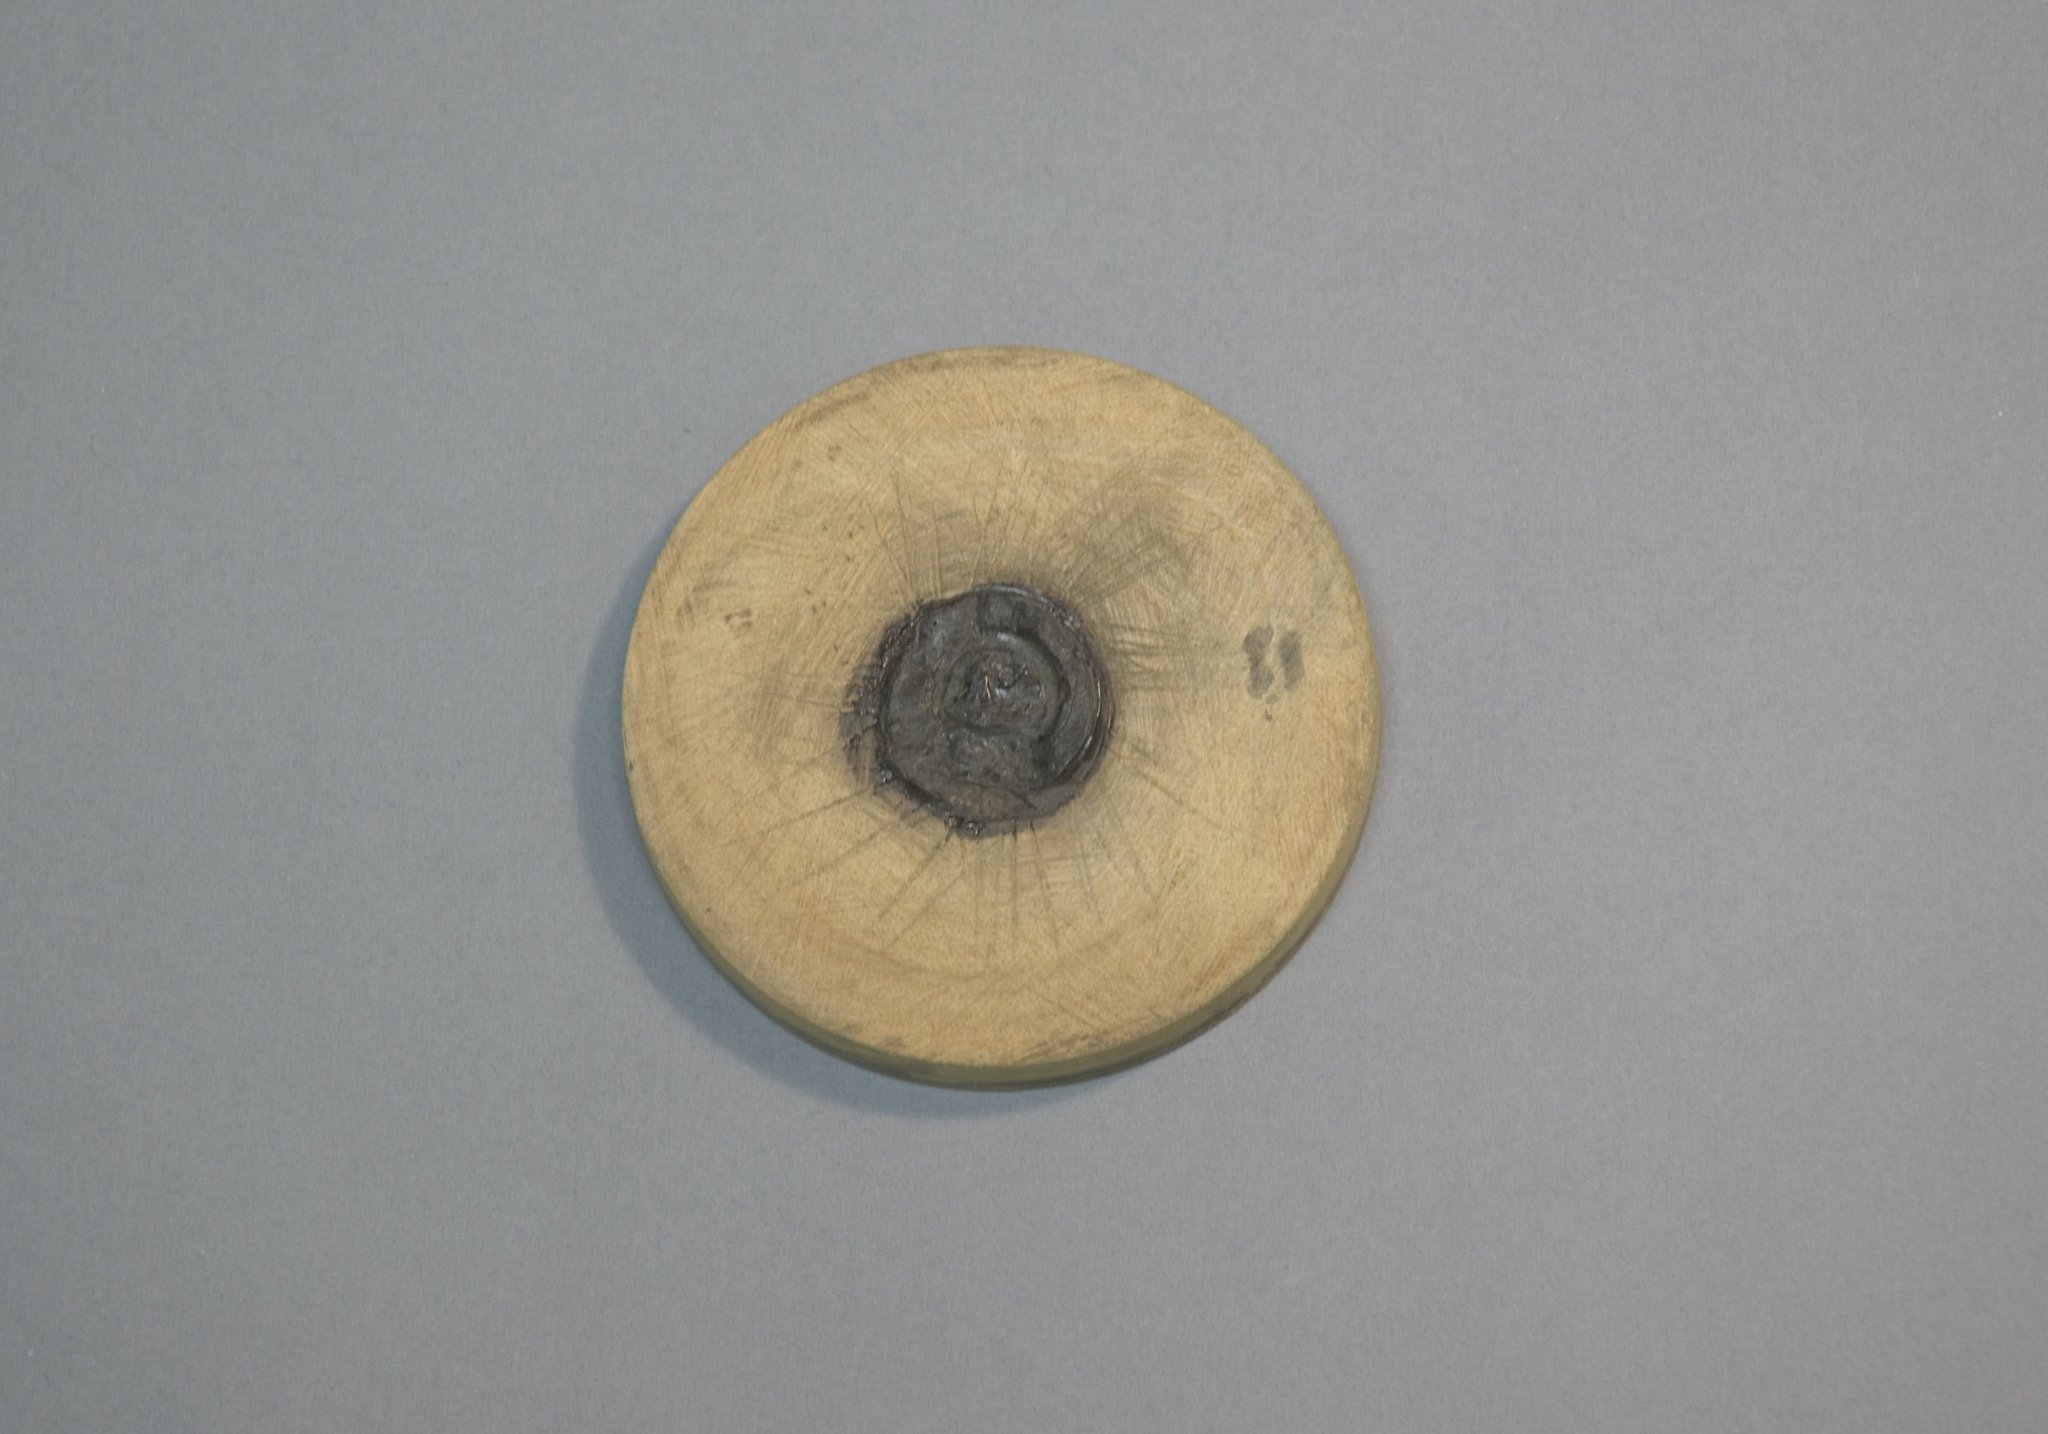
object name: jade carving tool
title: Polishing wheel for carving jade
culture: chinese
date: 1901-2000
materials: wood